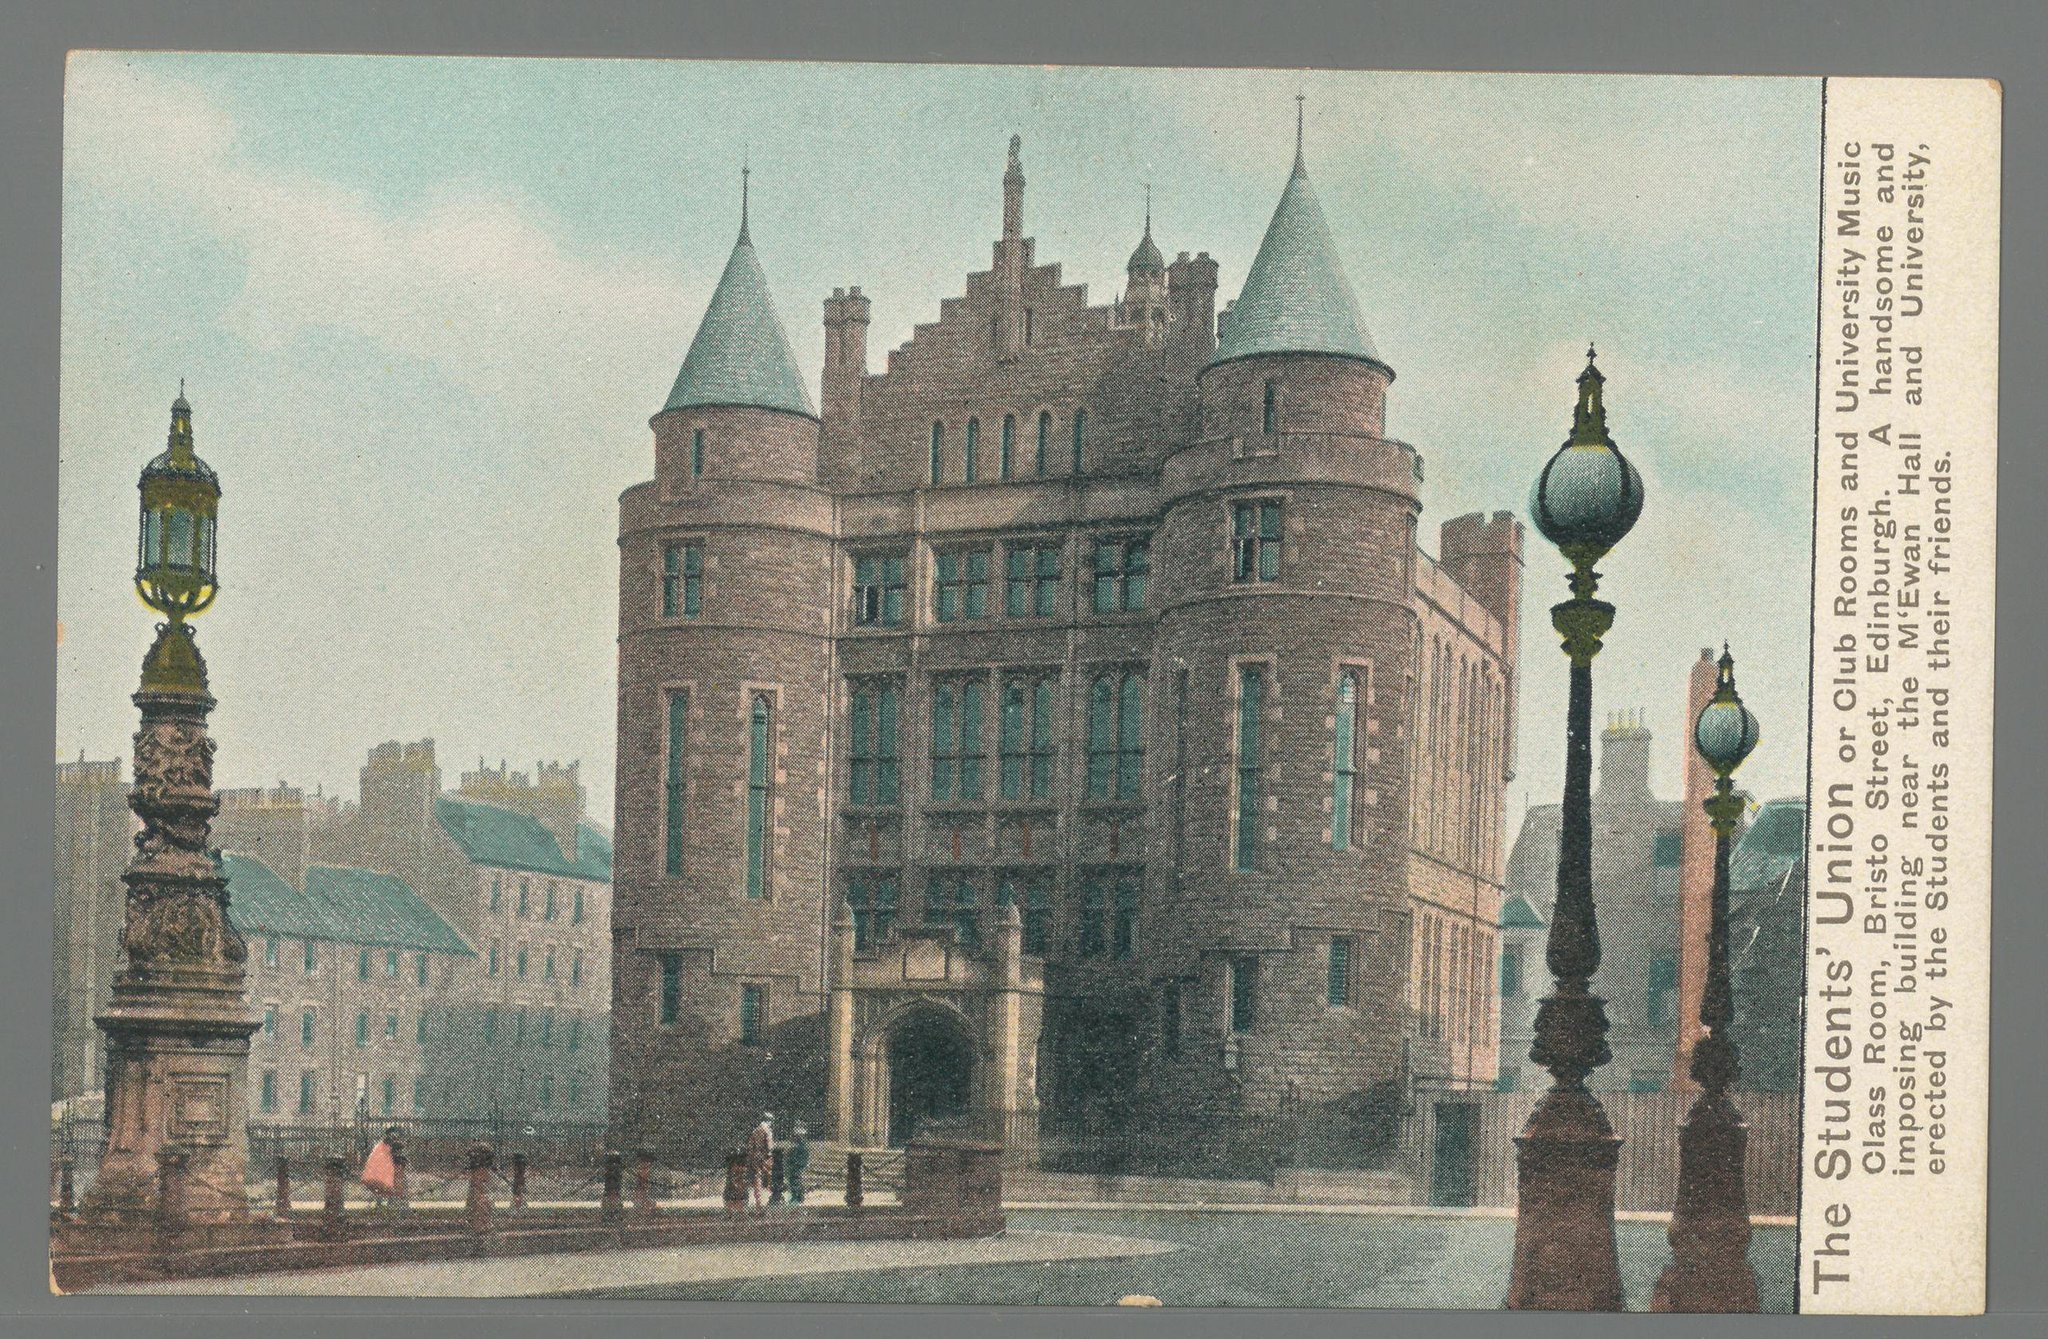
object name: ansichtkaart, prentbriefkaart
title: Edinburgh & London Series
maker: Anonymous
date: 1902-1918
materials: cardboard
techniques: lithograph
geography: edinburgh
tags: university building, college